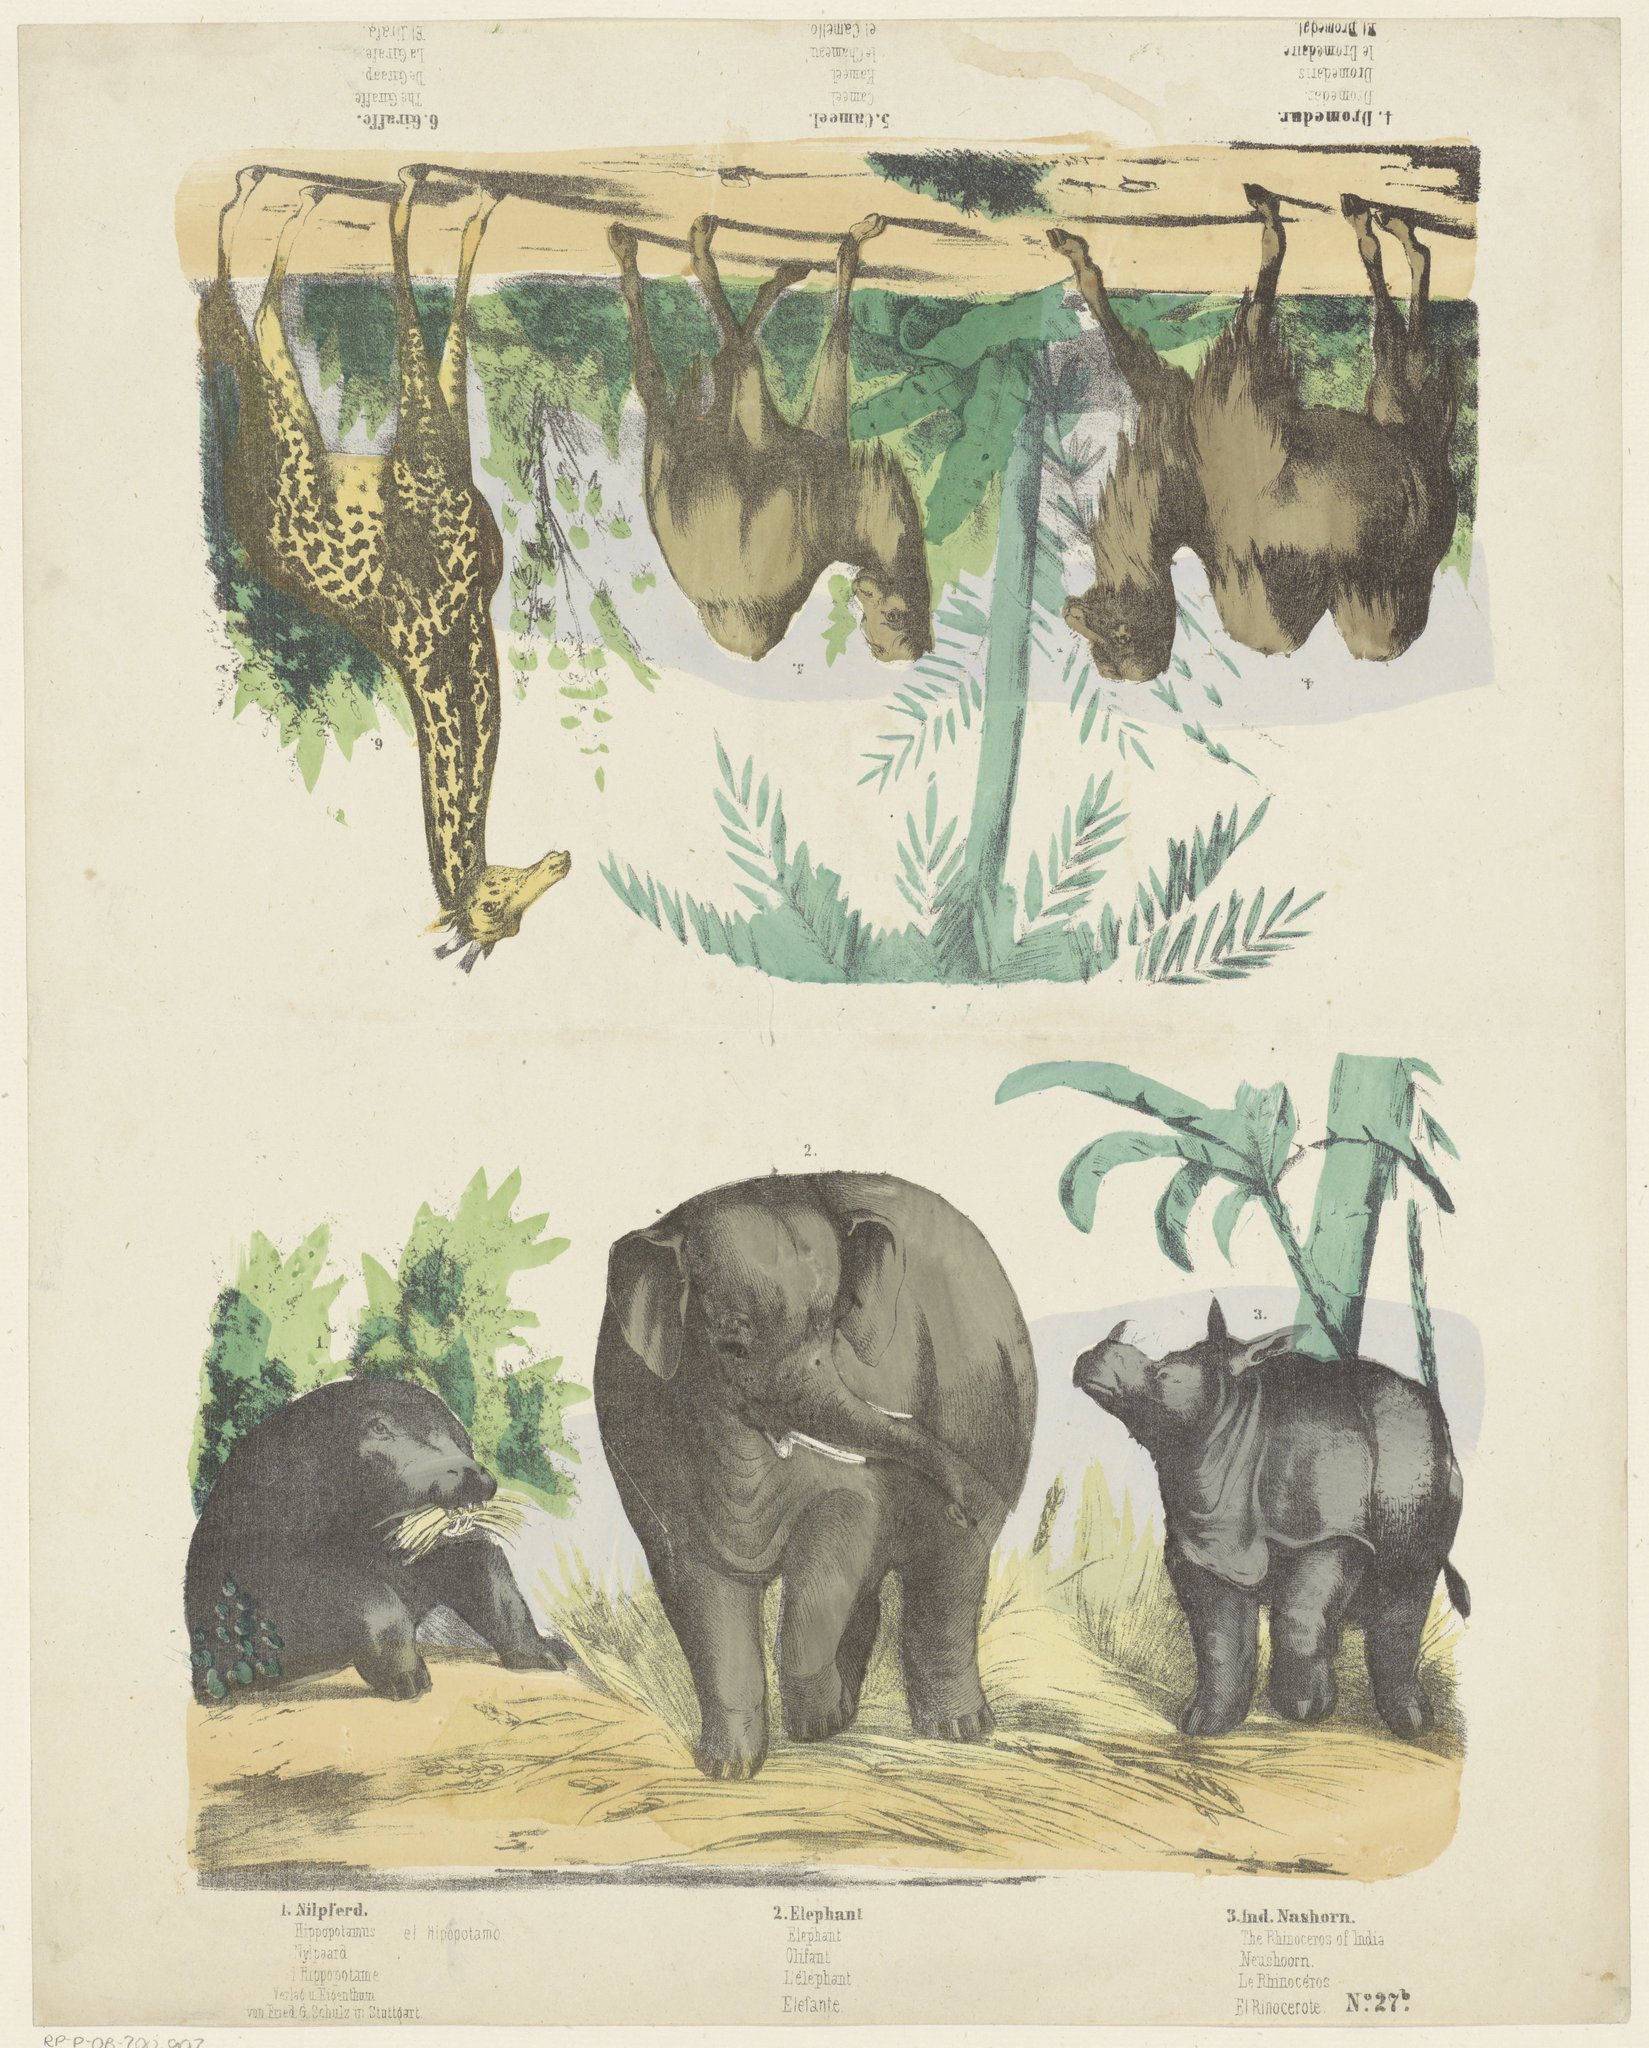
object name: print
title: Wilde dieren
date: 1820-1865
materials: paper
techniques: colour, lithograph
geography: europe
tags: hoofed animals: camel, hoofed animals: hippopotamus, hoofed animals: dromedary, animals, hoofed animals: rhinoceros, hoofed animals: giraffe, trunked animals: elephant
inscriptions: collector's mark: Lugt 2760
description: Blad met 2 voorstellingen van elk drie wilde dieren. Boven: (ondersteboven) een kameel, een dromedaris en een giraffe. Onder: een nijlpaard, een olifant en een neushoorn. Onder elke afbeelding de naam van het dier in vijf talen. Genummerd rechtsonder: No. 27b.